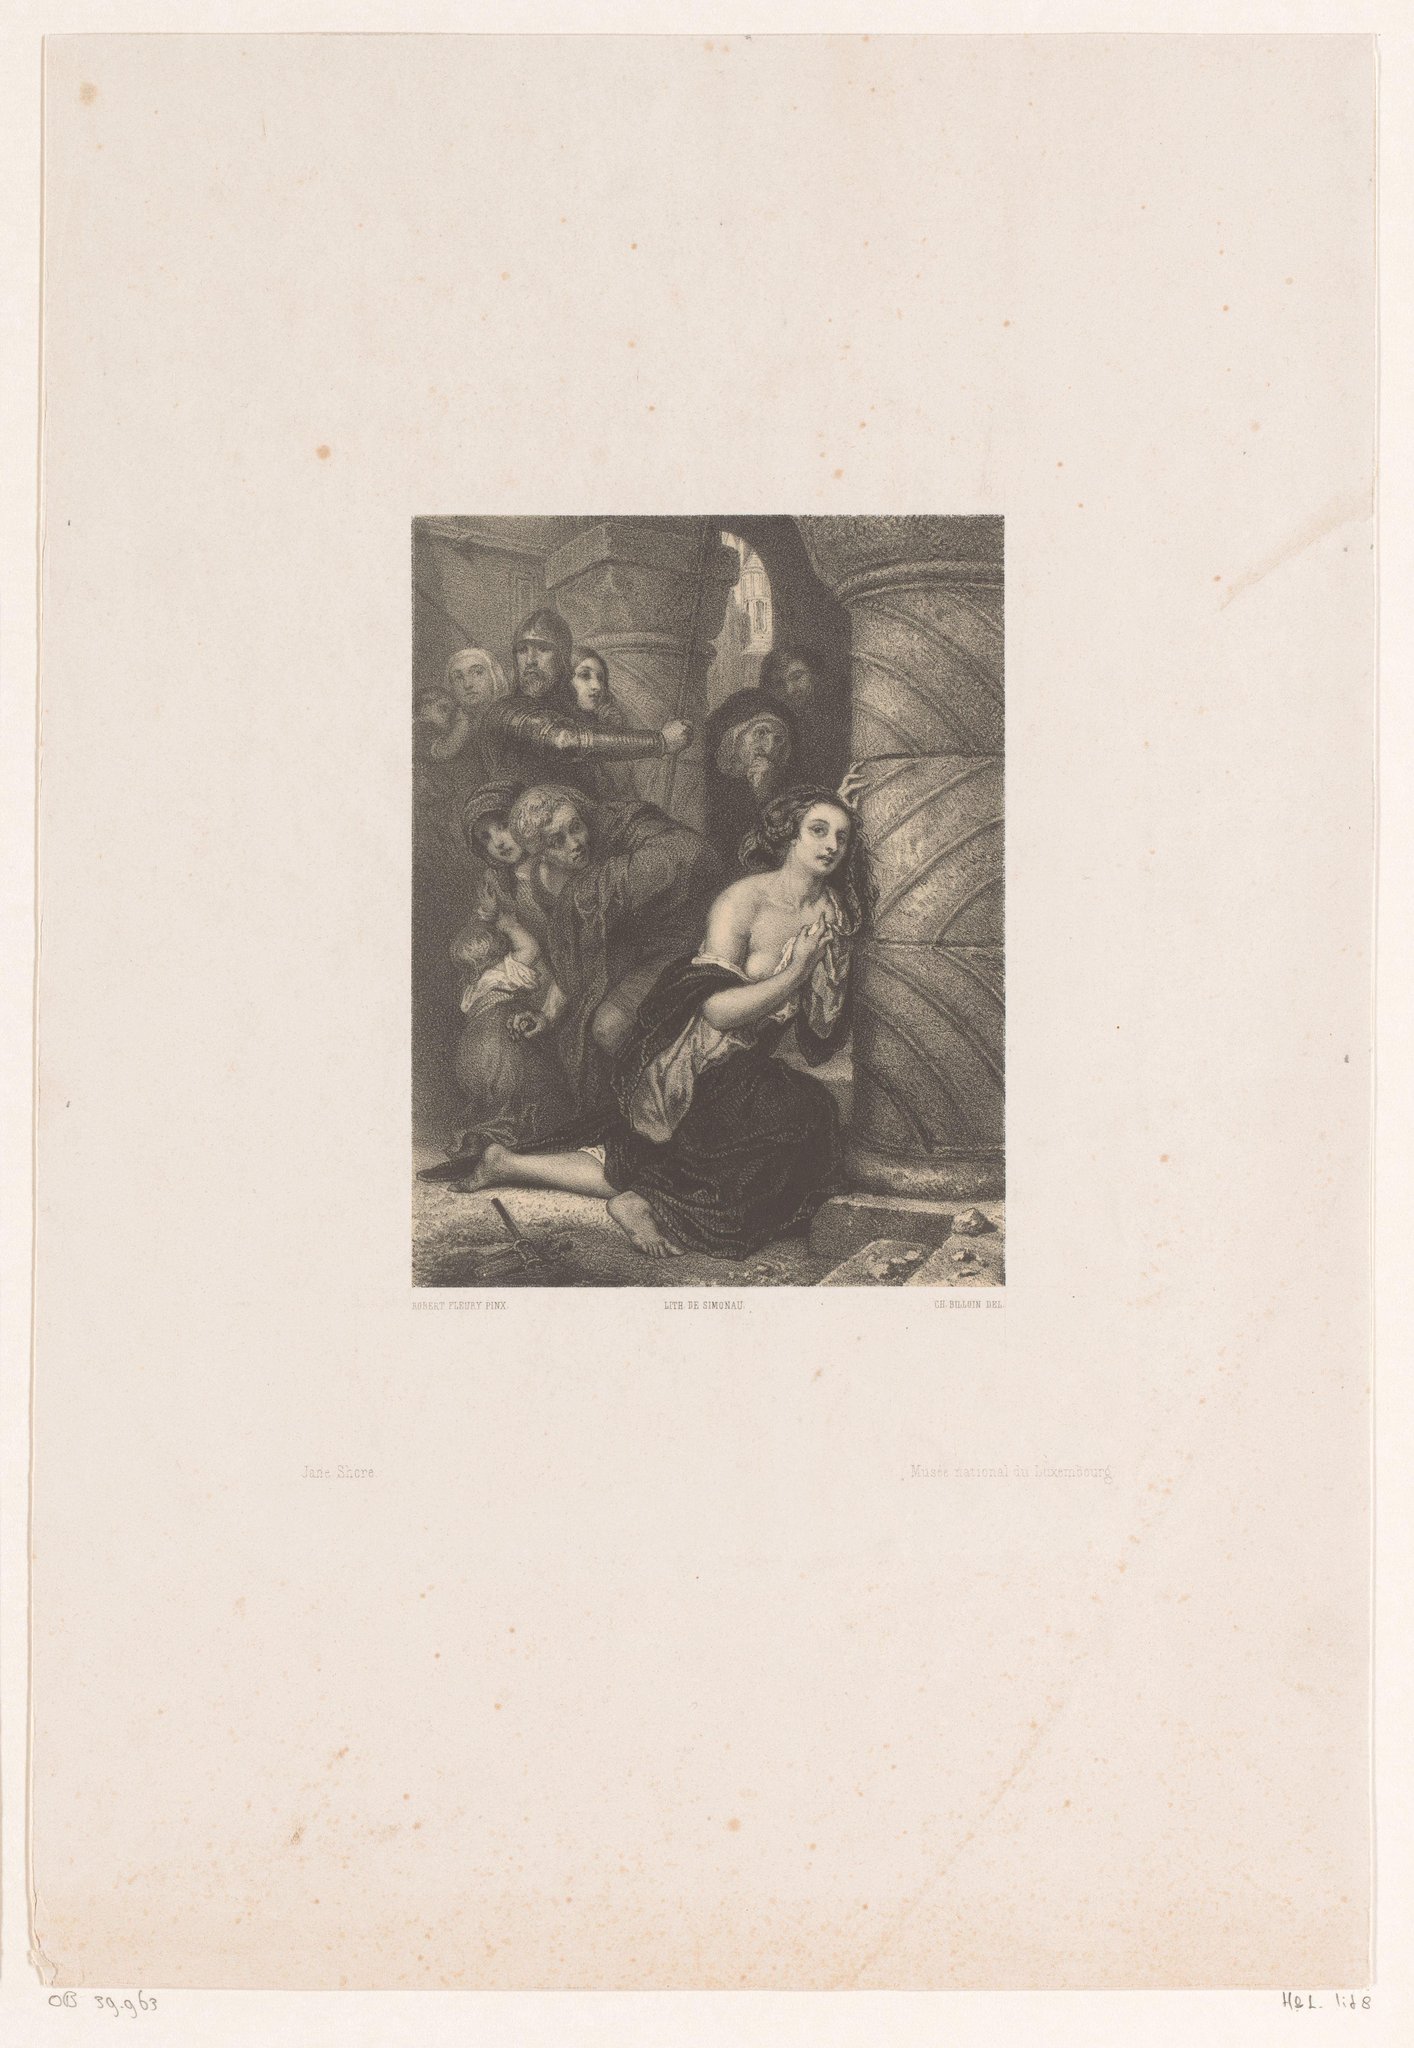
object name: print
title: Boetedoening van Jane Shore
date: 1848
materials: paper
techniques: lithograph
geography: brussels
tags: adult woman, column, pillar ~ architecture, public penance, general avowal of faults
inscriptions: collector's mark: Lugt 2228, inscription: ‘Musée national du Luxembourg’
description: Prent verschenen in: Revue de Belgique: littérature et beaux-arts 2 (1848).